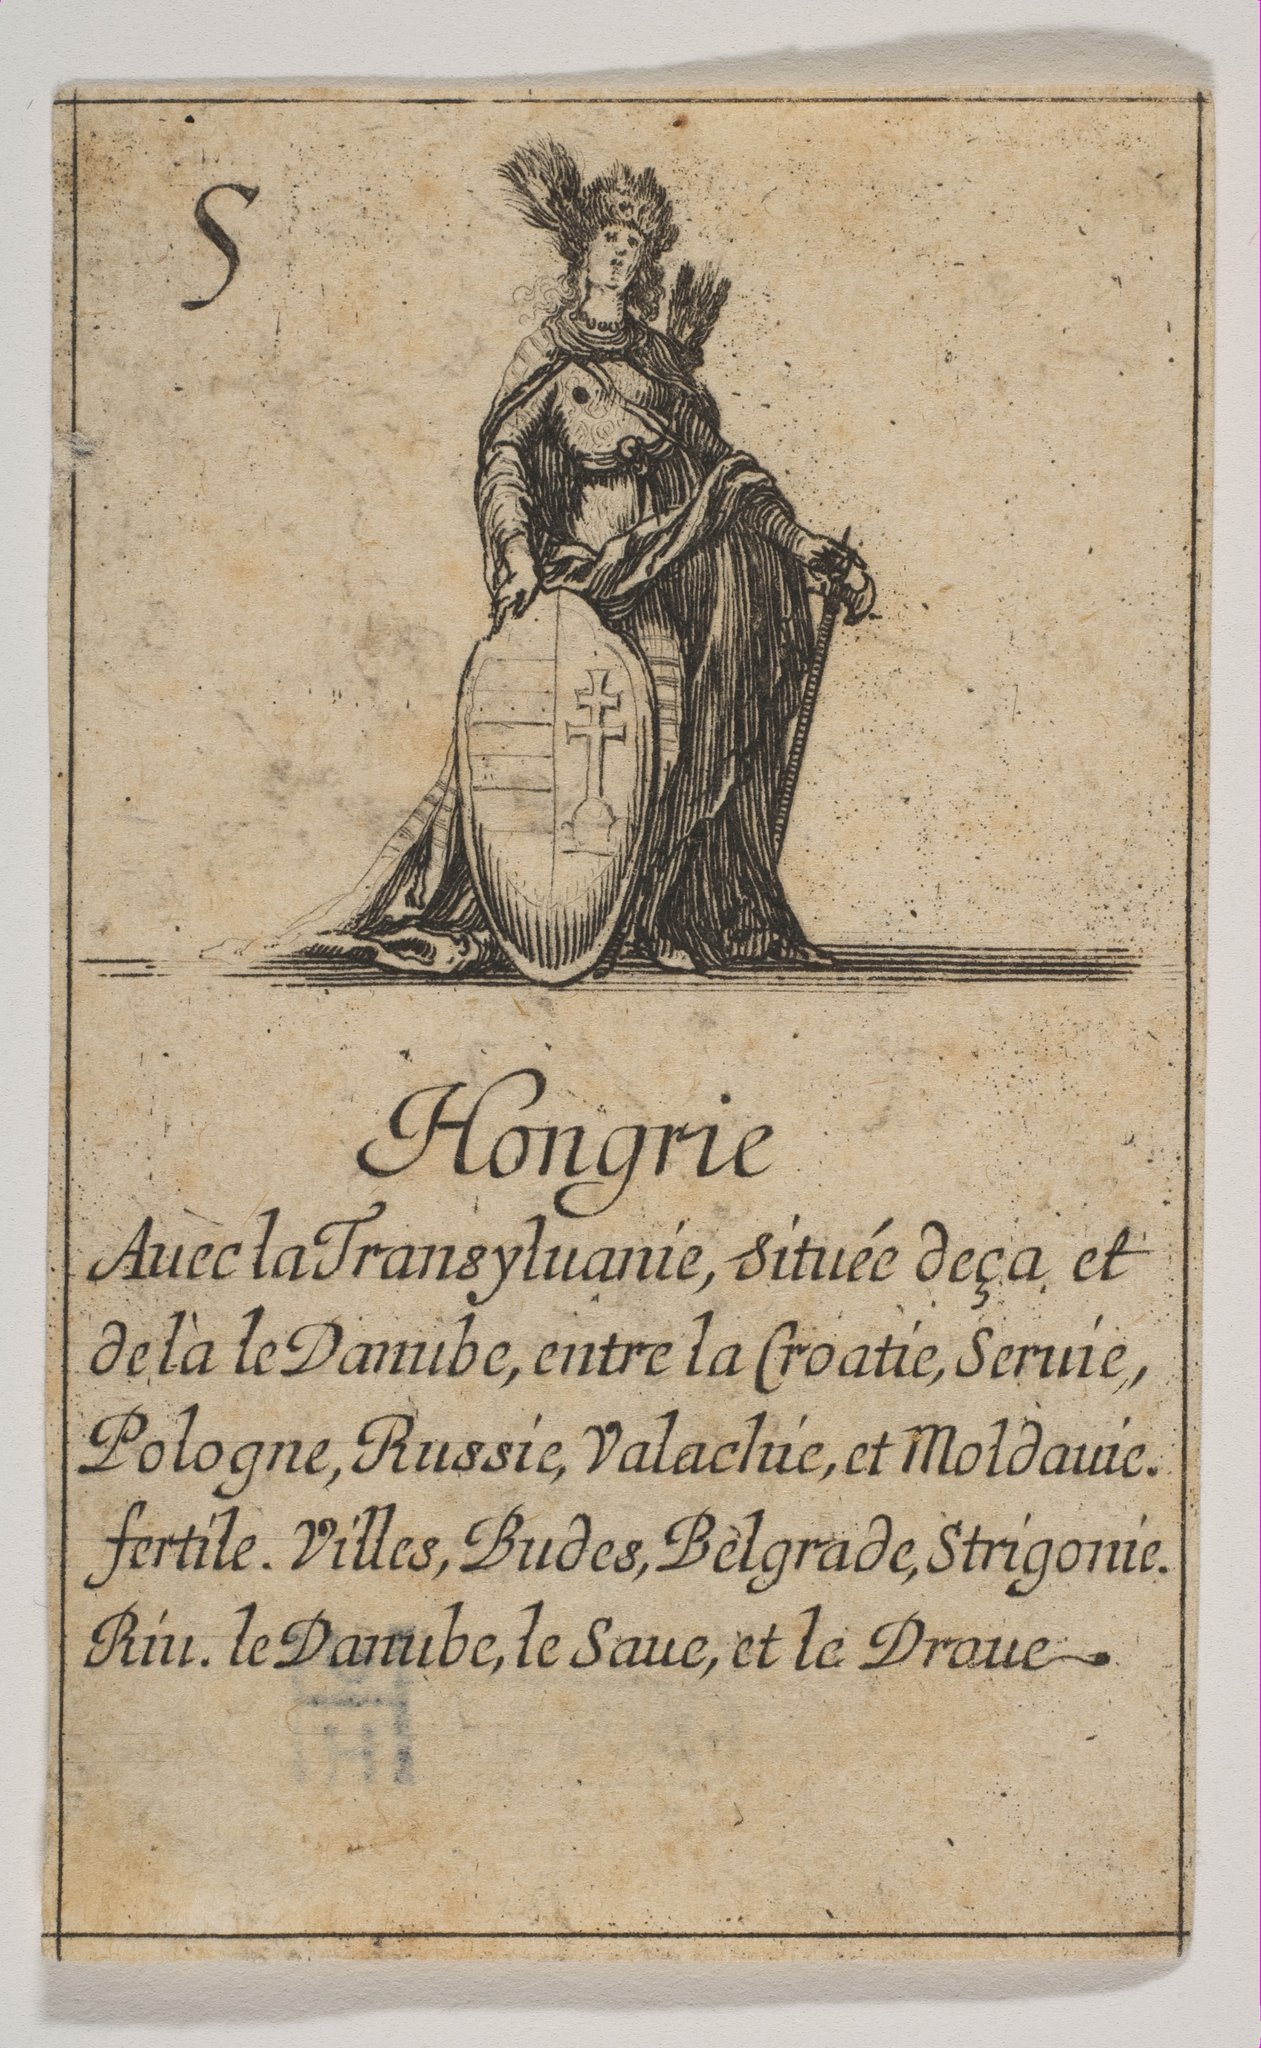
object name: print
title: Hongrie, from "Jeu de la Géographie"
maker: stefano della bella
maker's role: artist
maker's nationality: italian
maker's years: 1610-1664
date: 1644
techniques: etching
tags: shields,women